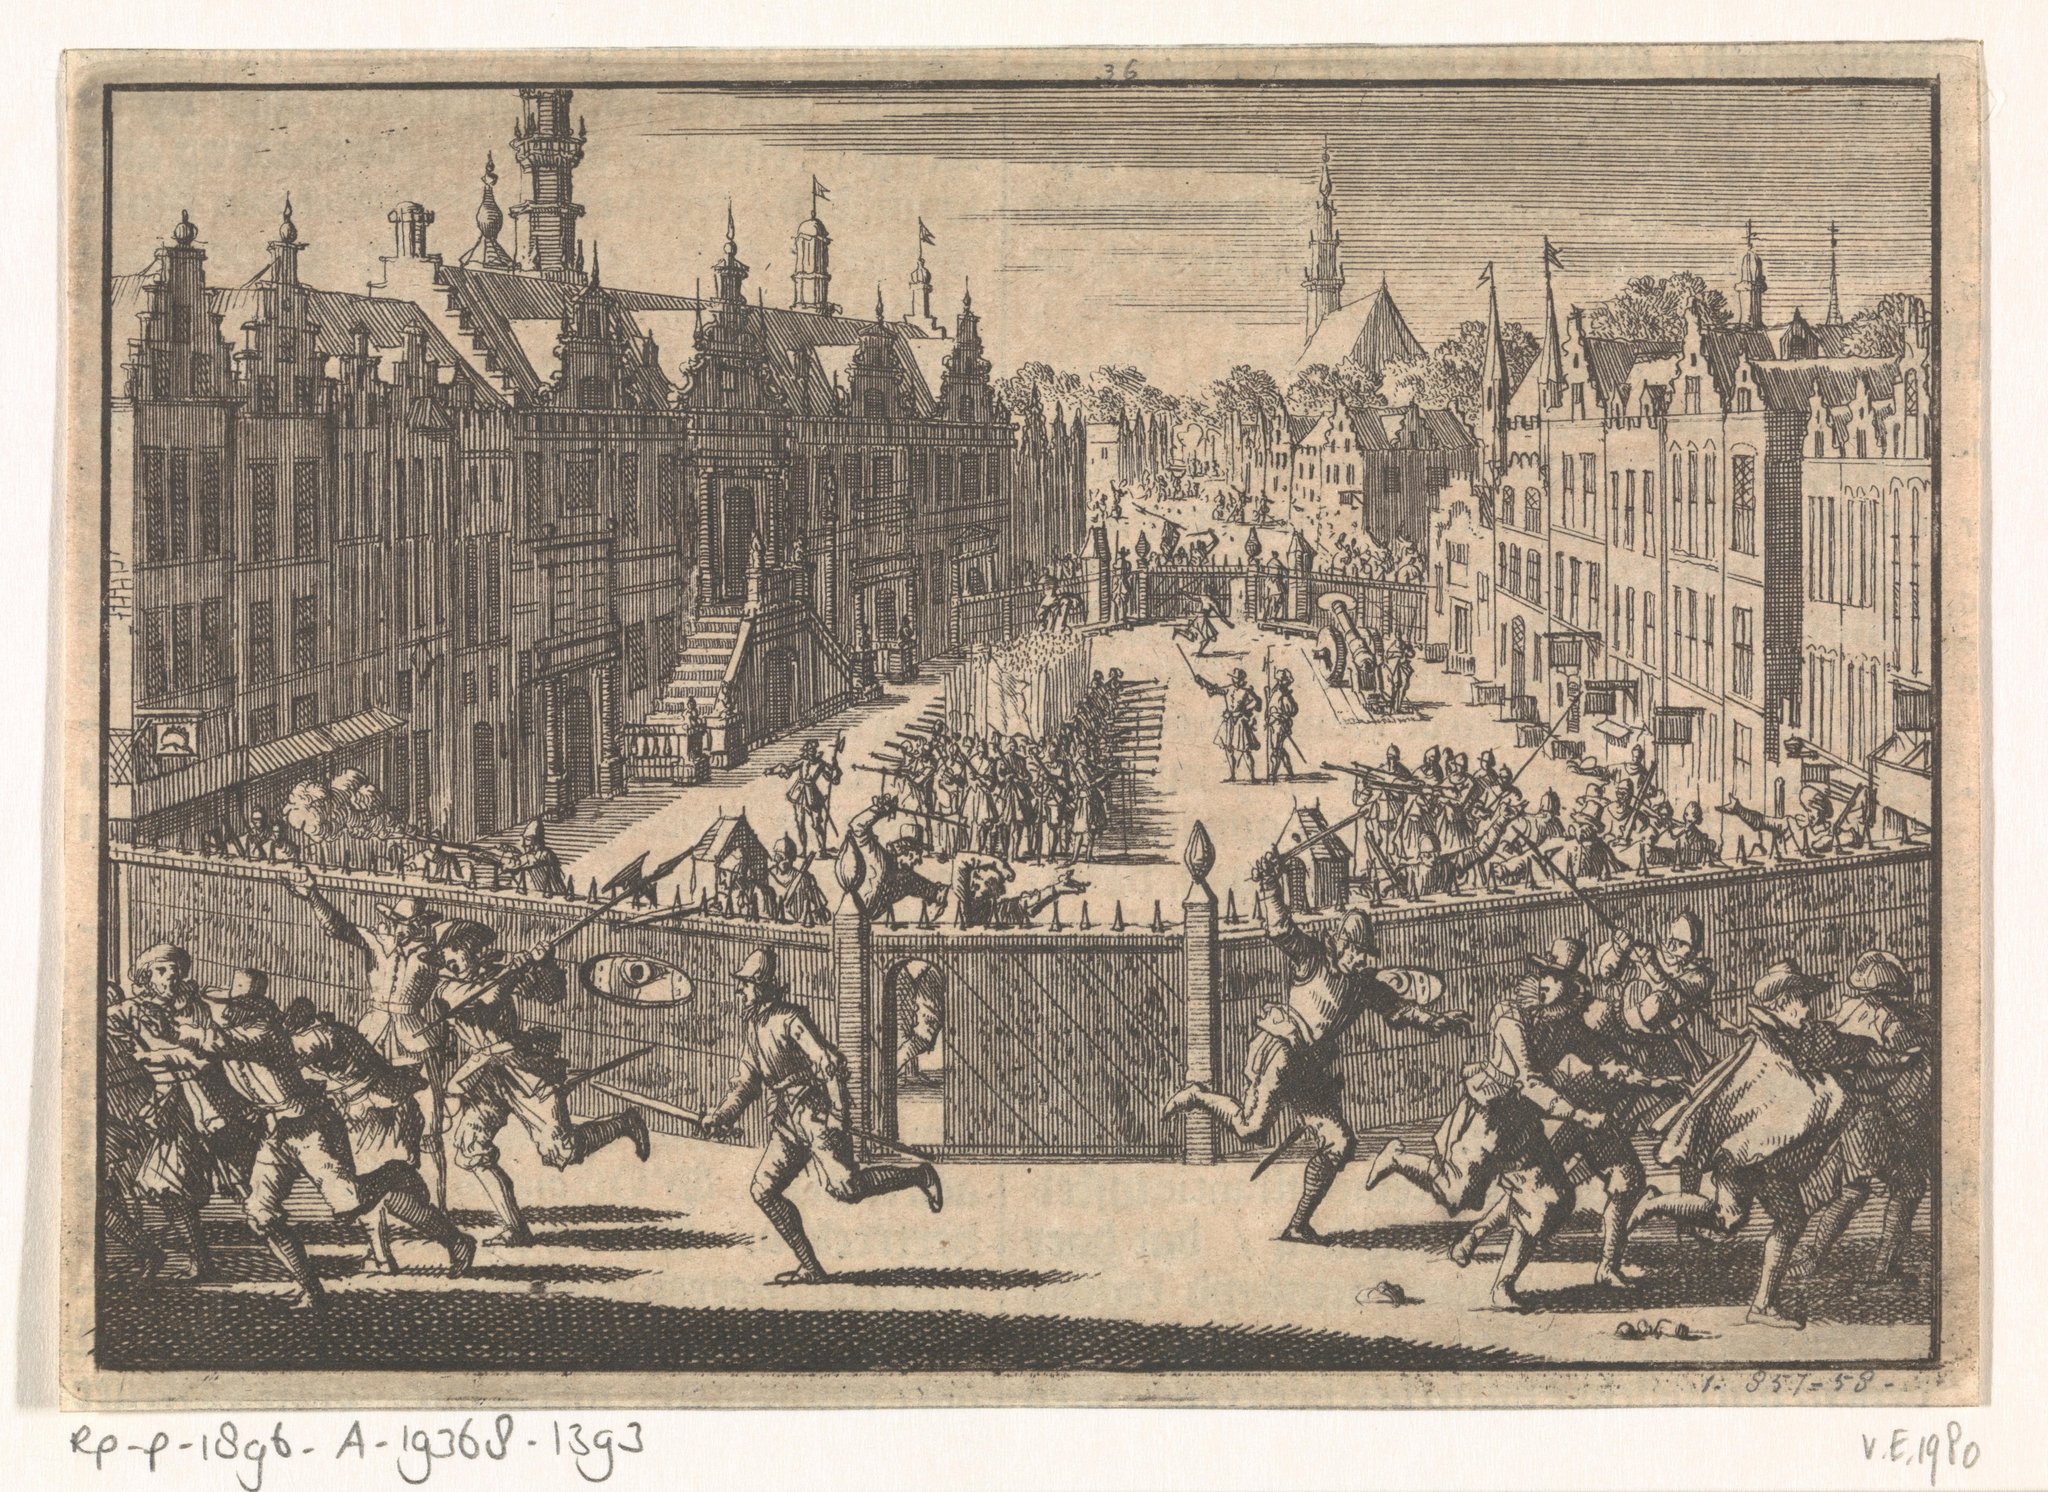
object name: book illustration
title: Breestraat te Leiden door Waardgelders bezet, 1618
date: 1698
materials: paper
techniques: etching, letterpress printing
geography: leiden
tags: capture of city (after the siege) (+ variant)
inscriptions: collector's mark: Lugt 2228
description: Illustratie uit: Gottfried, Johann Ludwig. Historische kronyck; vervattende een (...) beschrijvingh der aldergedenckwaerdigste geschiedenissen des weerelds, van den aenvangh der scheppingh tot (...) 1576 (2 delen). Leiden: Pieter van der Aa, 1698, dl. I, p. 857.